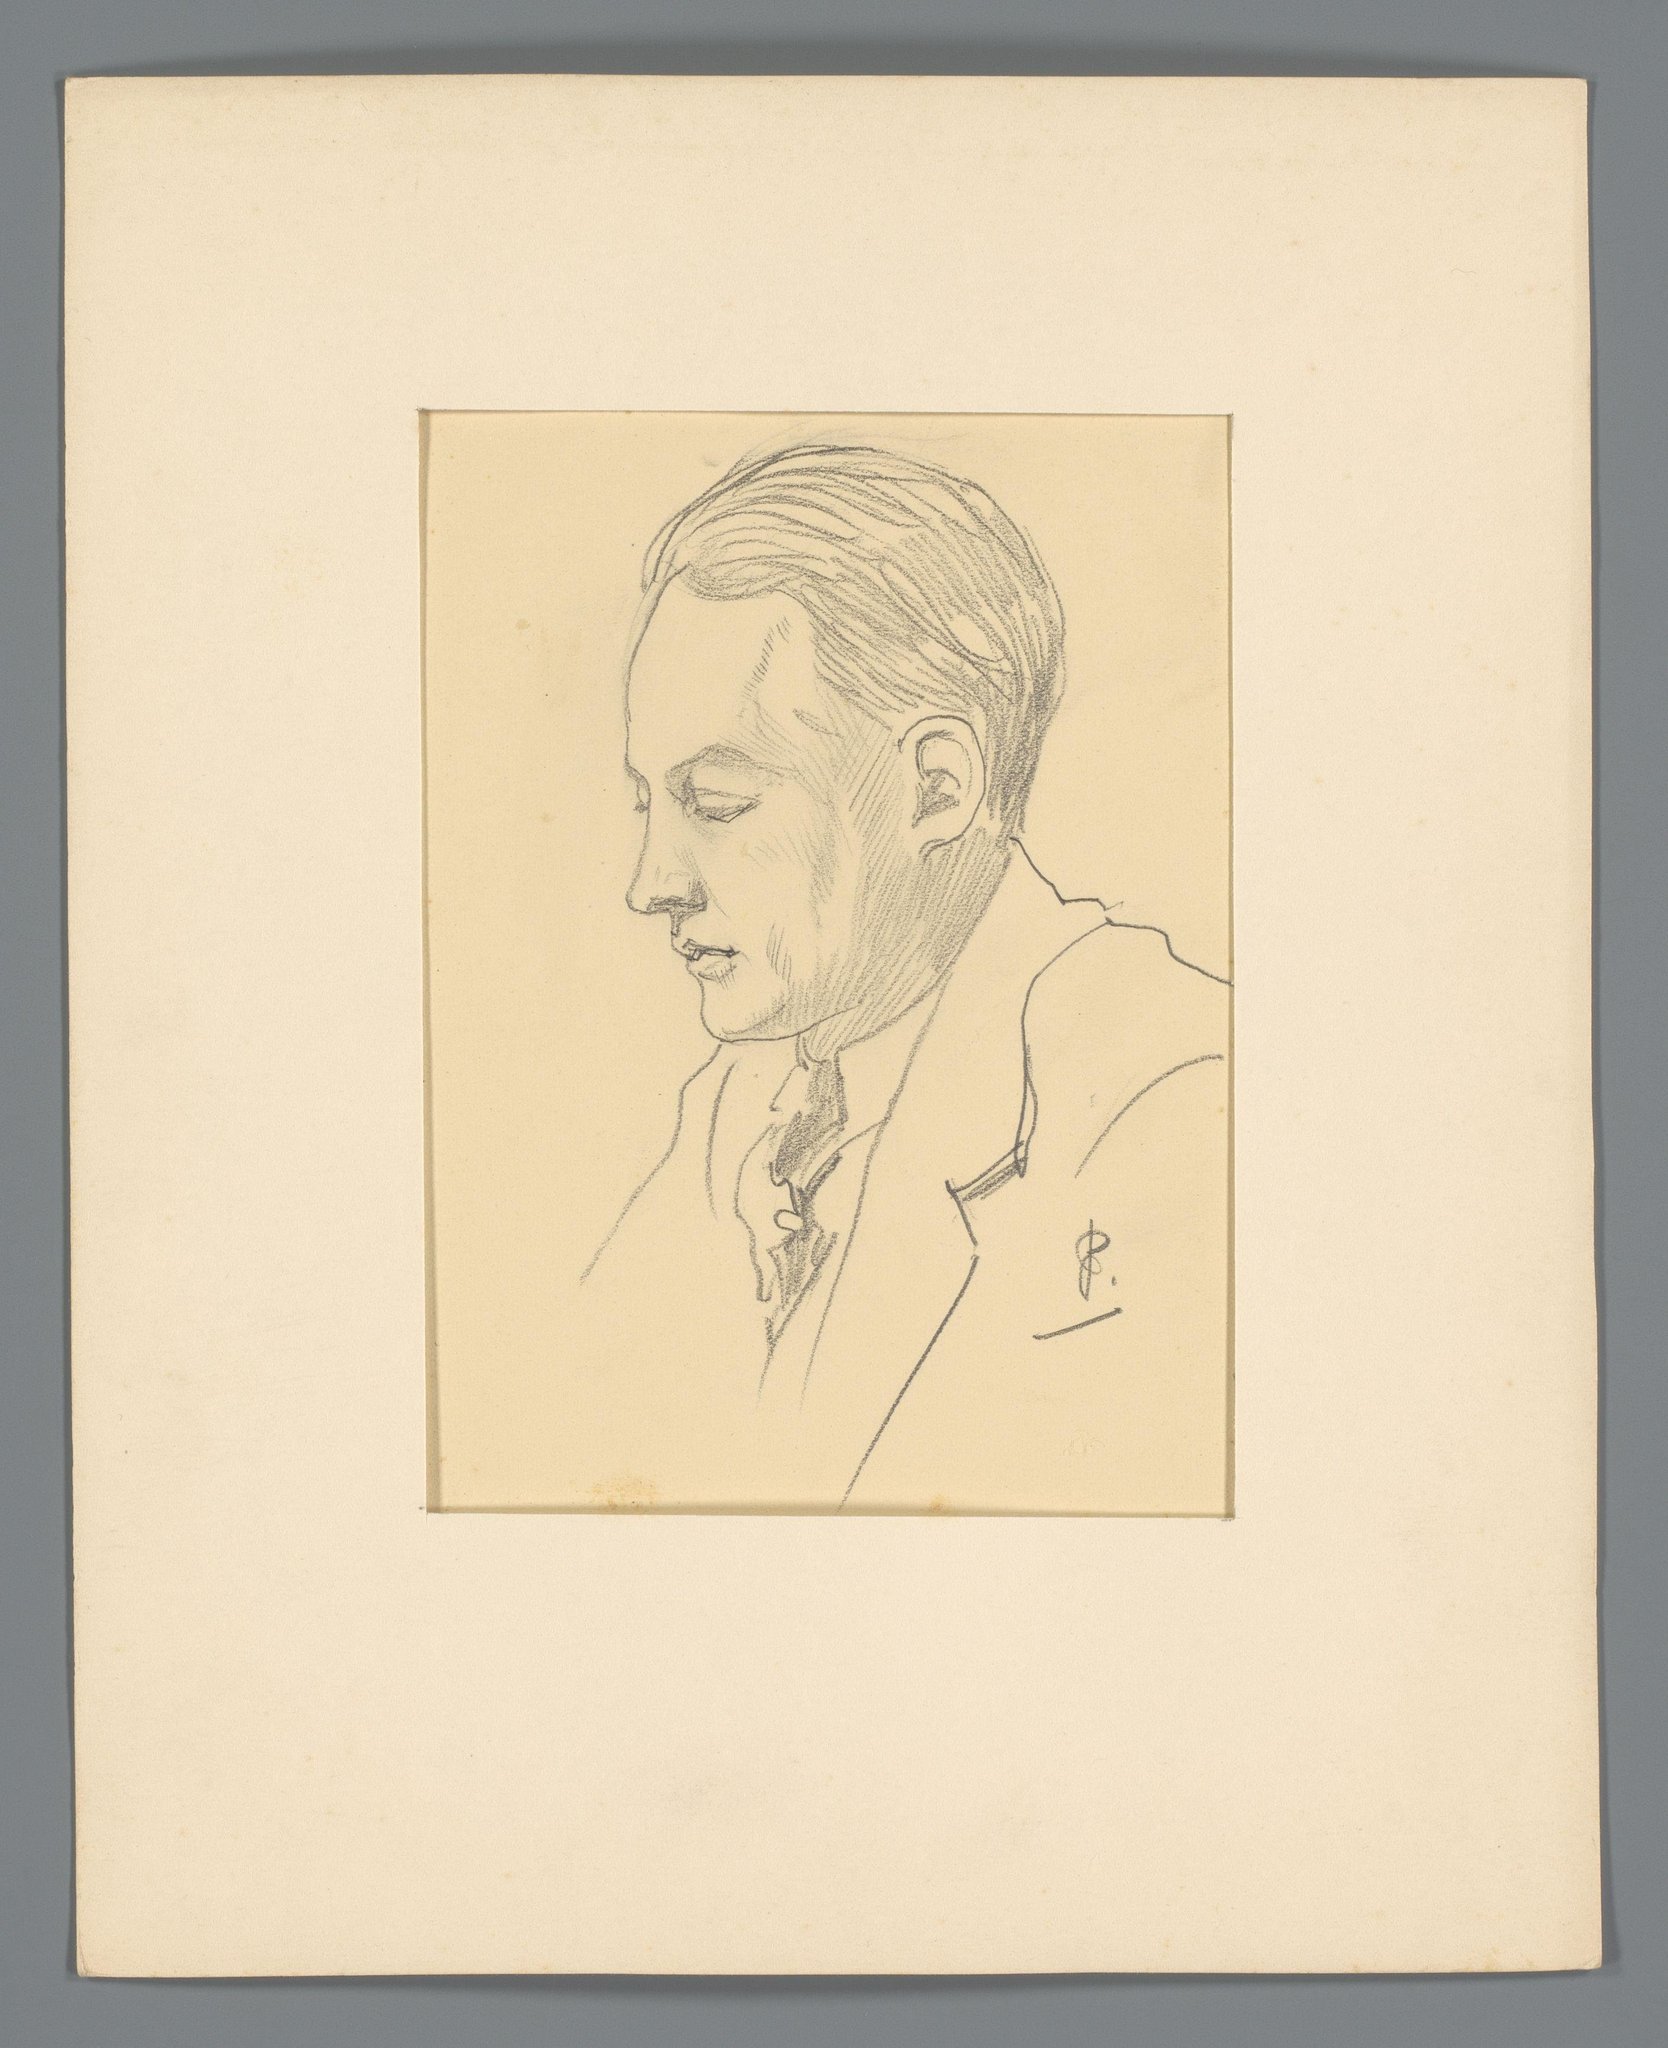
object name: drawing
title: Portret van een man, mogelijk A. Kraaij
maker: Anonymous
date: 1920-1986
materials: paper, pencil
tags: historical persons not known by name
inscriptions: signature: ‘P.’